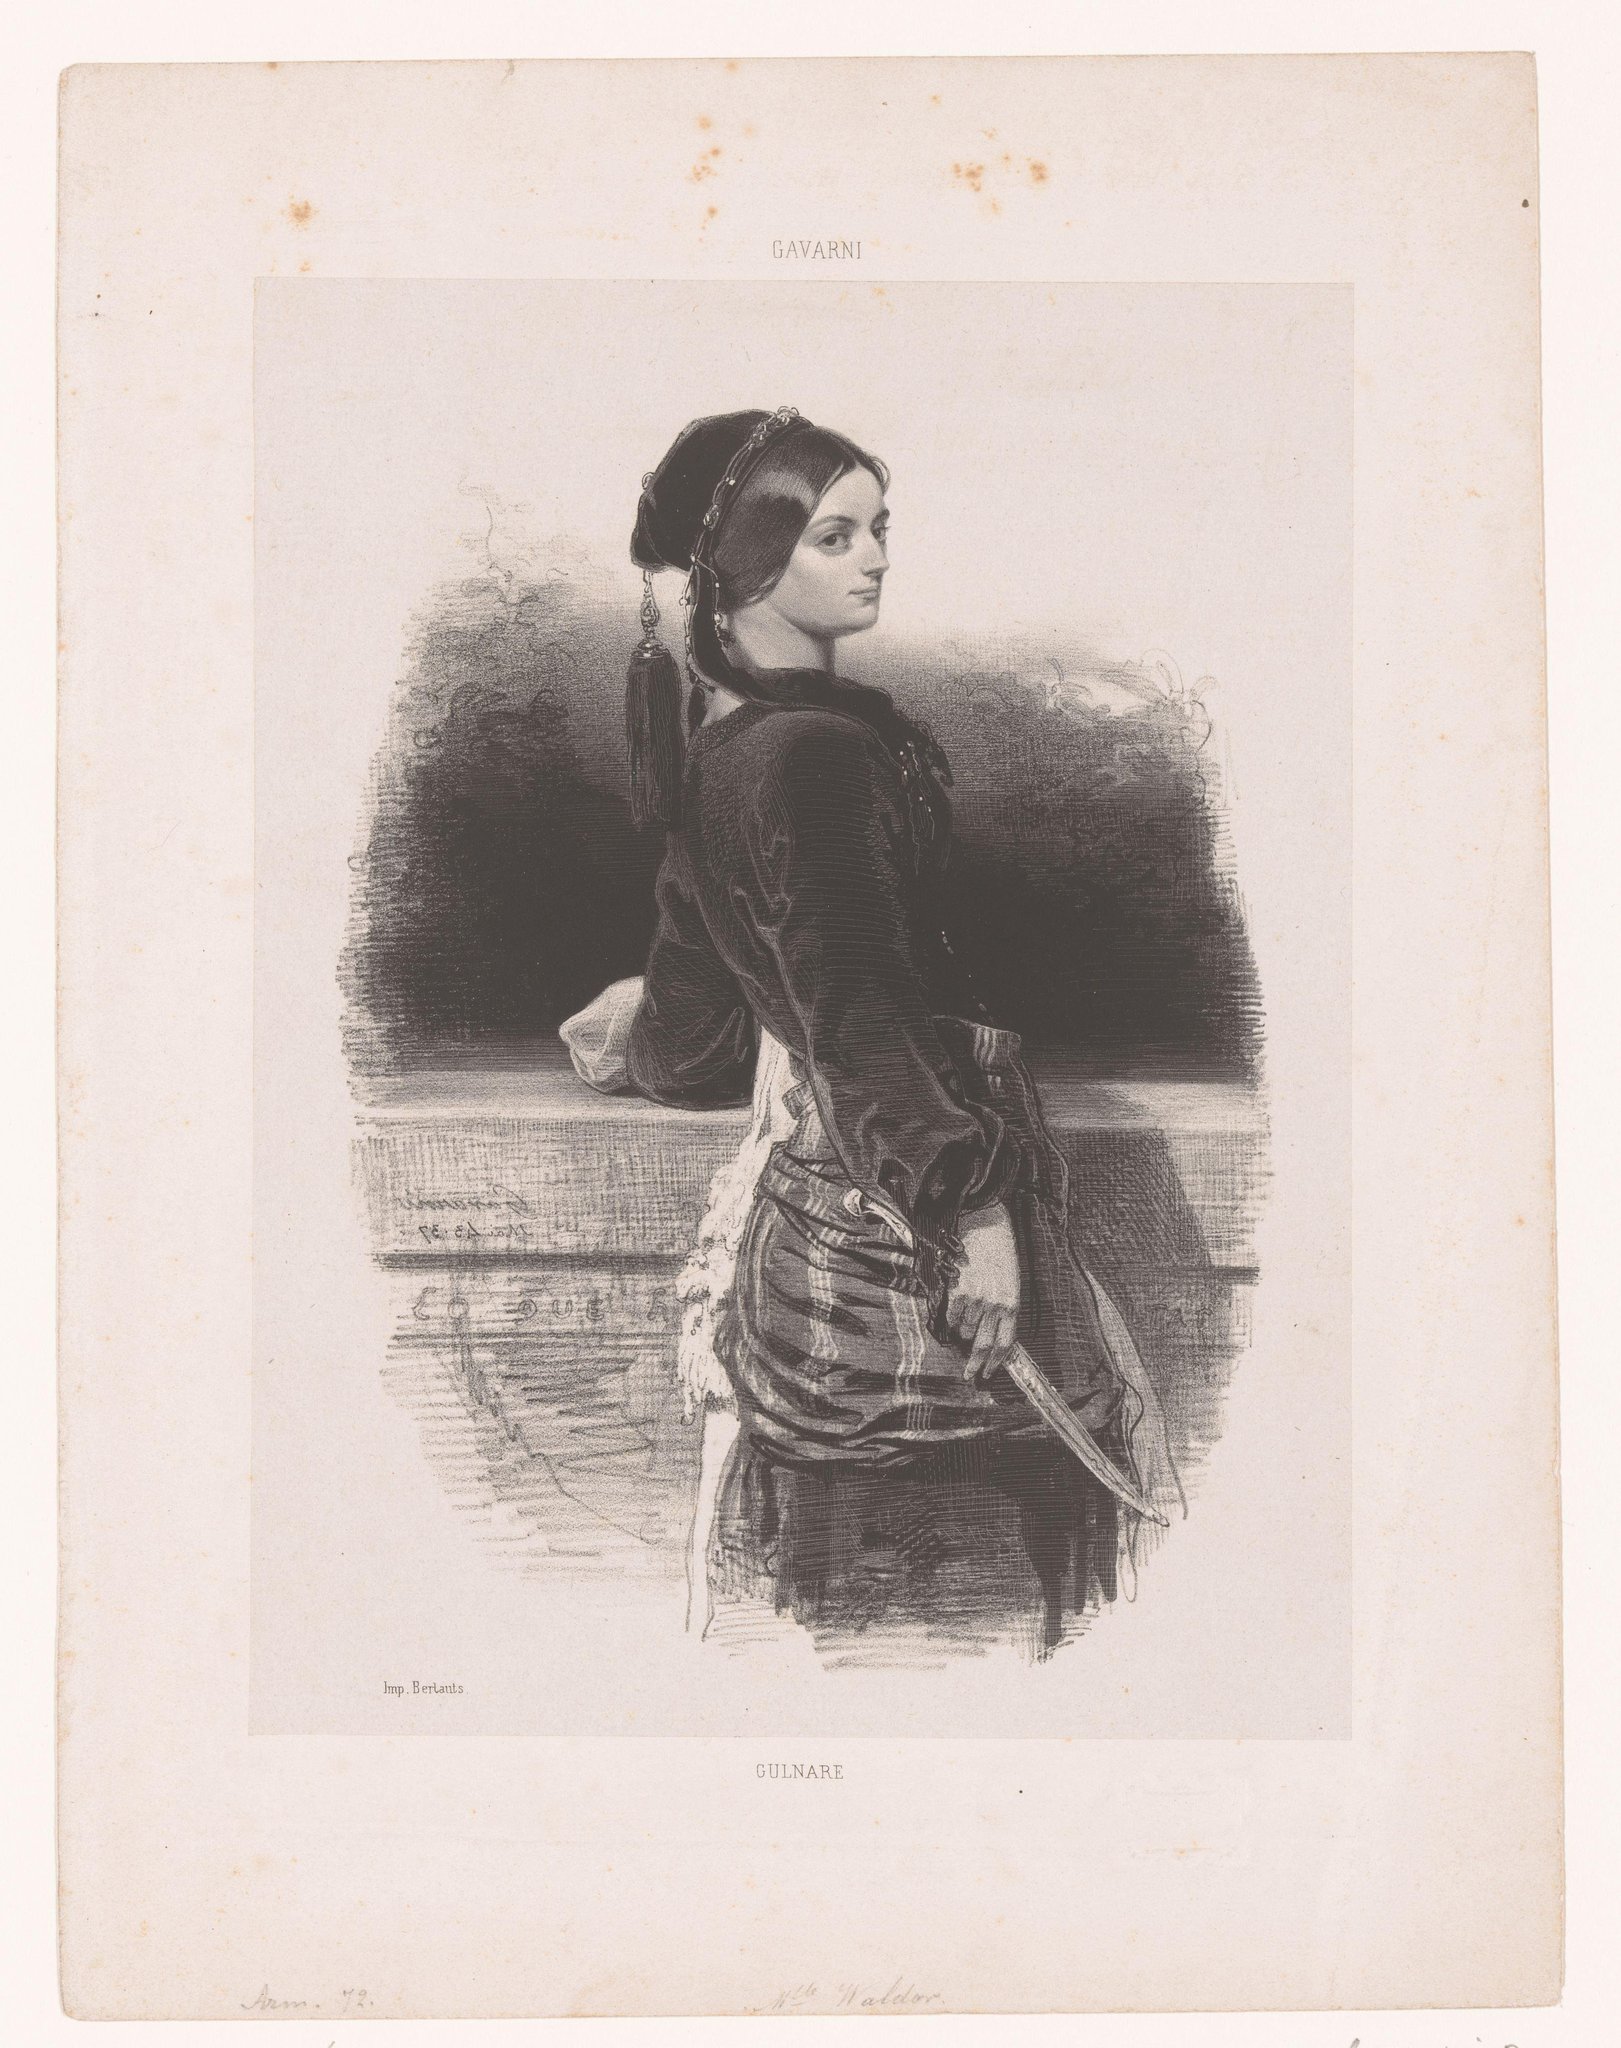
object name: book illustration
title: Portret van Mélanie Waldor als Gulnare uit Le Corsaire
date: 1843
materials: paper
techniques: lithograph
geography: paris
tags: paris, historical persons, slavery; serfs and enslaved persons, portrait of actor, actress, stage costume - cc - female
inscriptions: check stamp: Lugt 470b, collector's mark: Lugt 2228a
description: Mélanie Waldor in de rol van Gulnare, een Perzische tot slaaf gemaakte vrouw die een hoofdrol speelt in het ballet Le Corsaire.